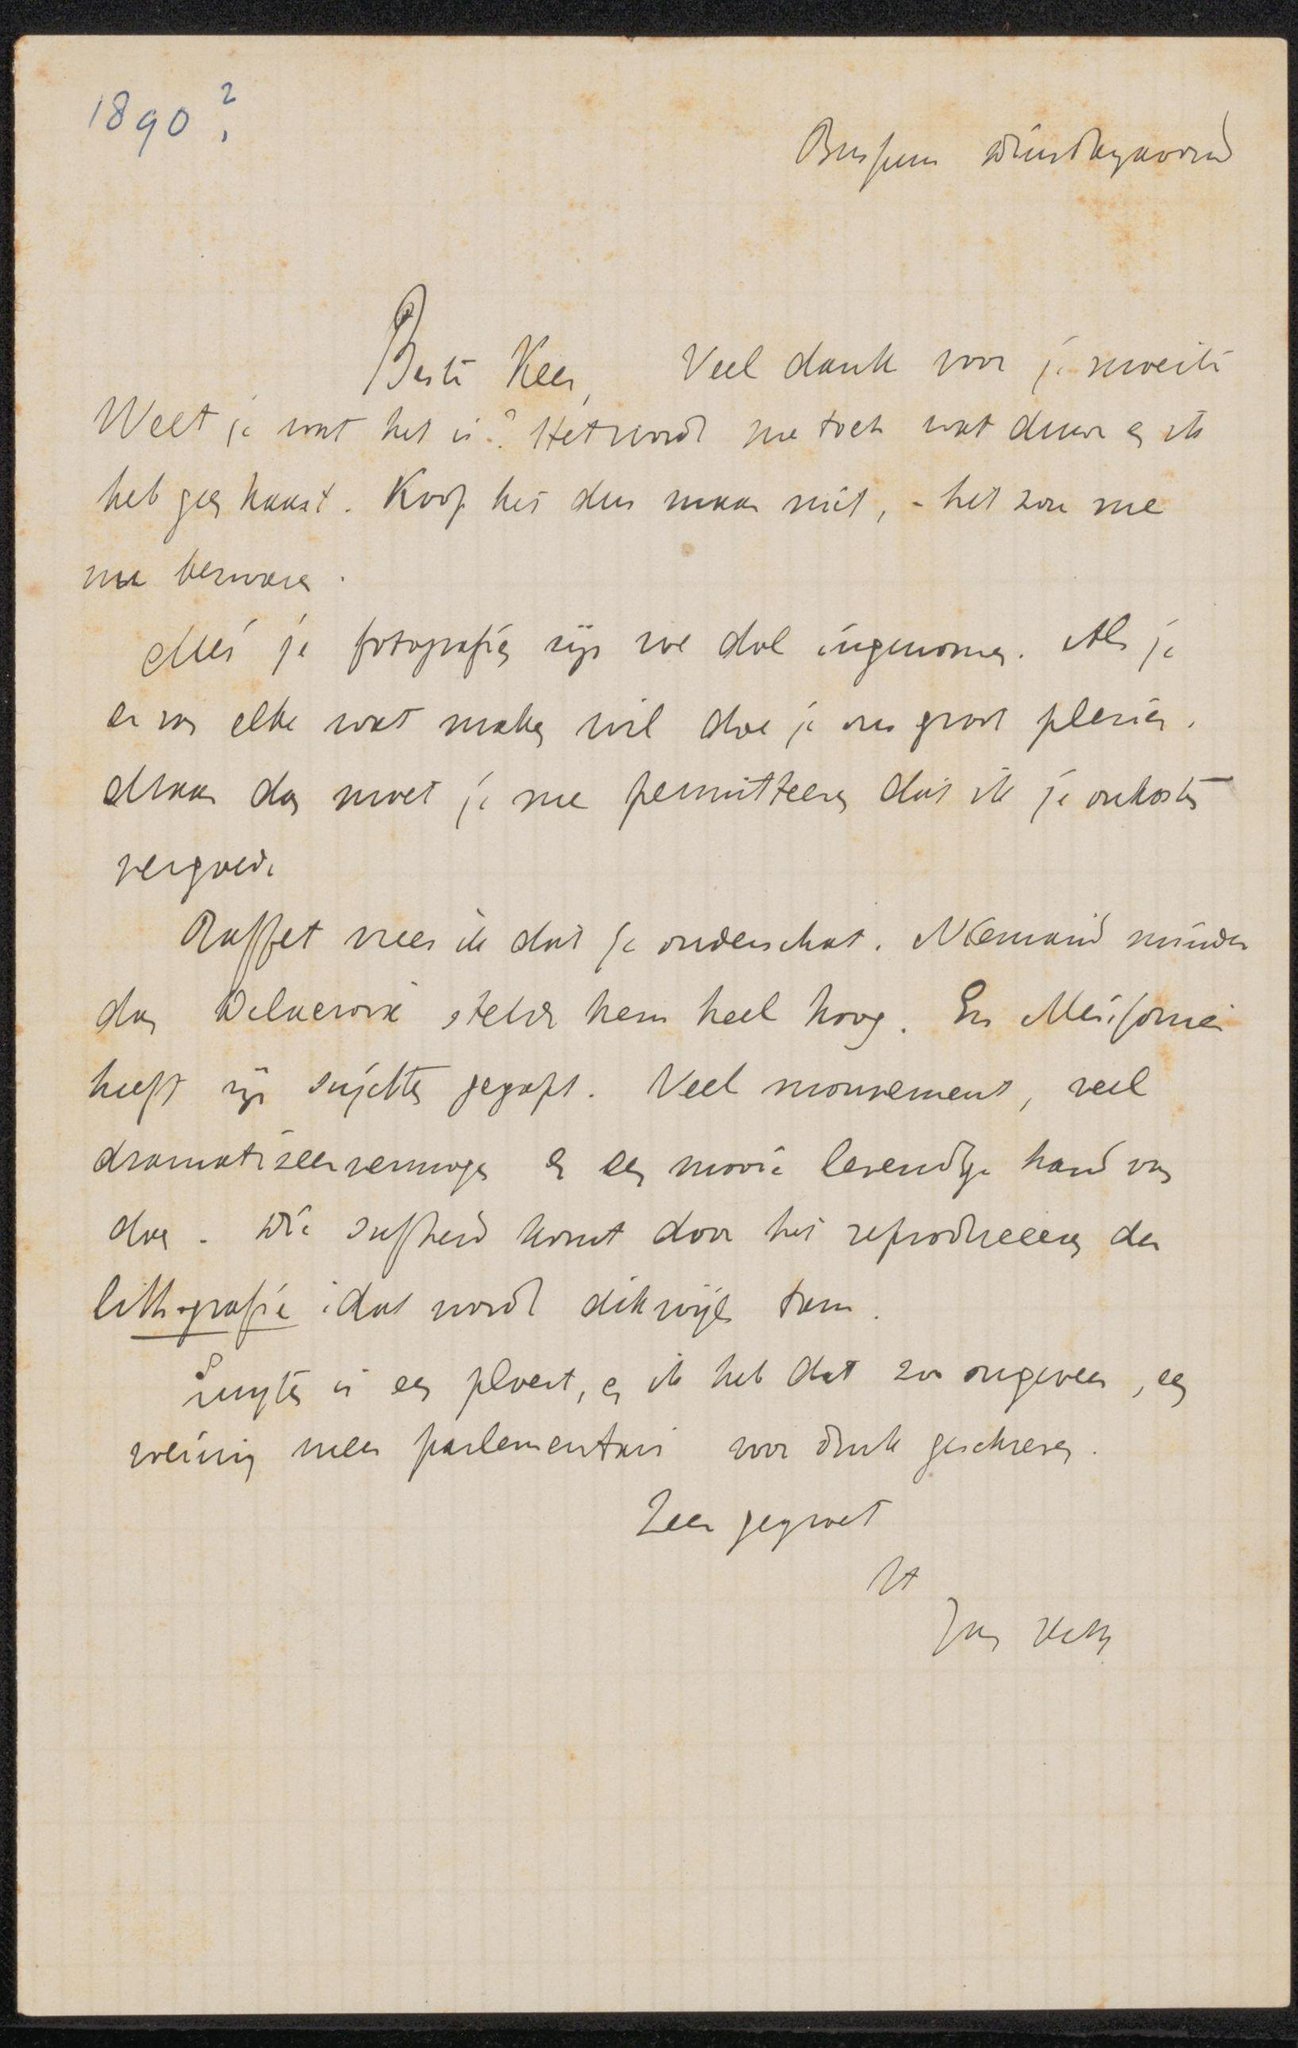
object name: letter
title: Brief aan Cornelis Gerardus 't Hooft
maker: jan veth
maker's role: designer, draughtsman, painter, print maker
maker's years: 1864-1925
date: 1876-1925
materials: ink, paper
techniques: pen, writing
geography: bussum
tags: paris, print maker, draughtsman, denis auguste marie raffet, cornelis gerardus 't hooft, photography, cinematography, the graphic arts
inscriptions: collector's mark: ‘RPK’